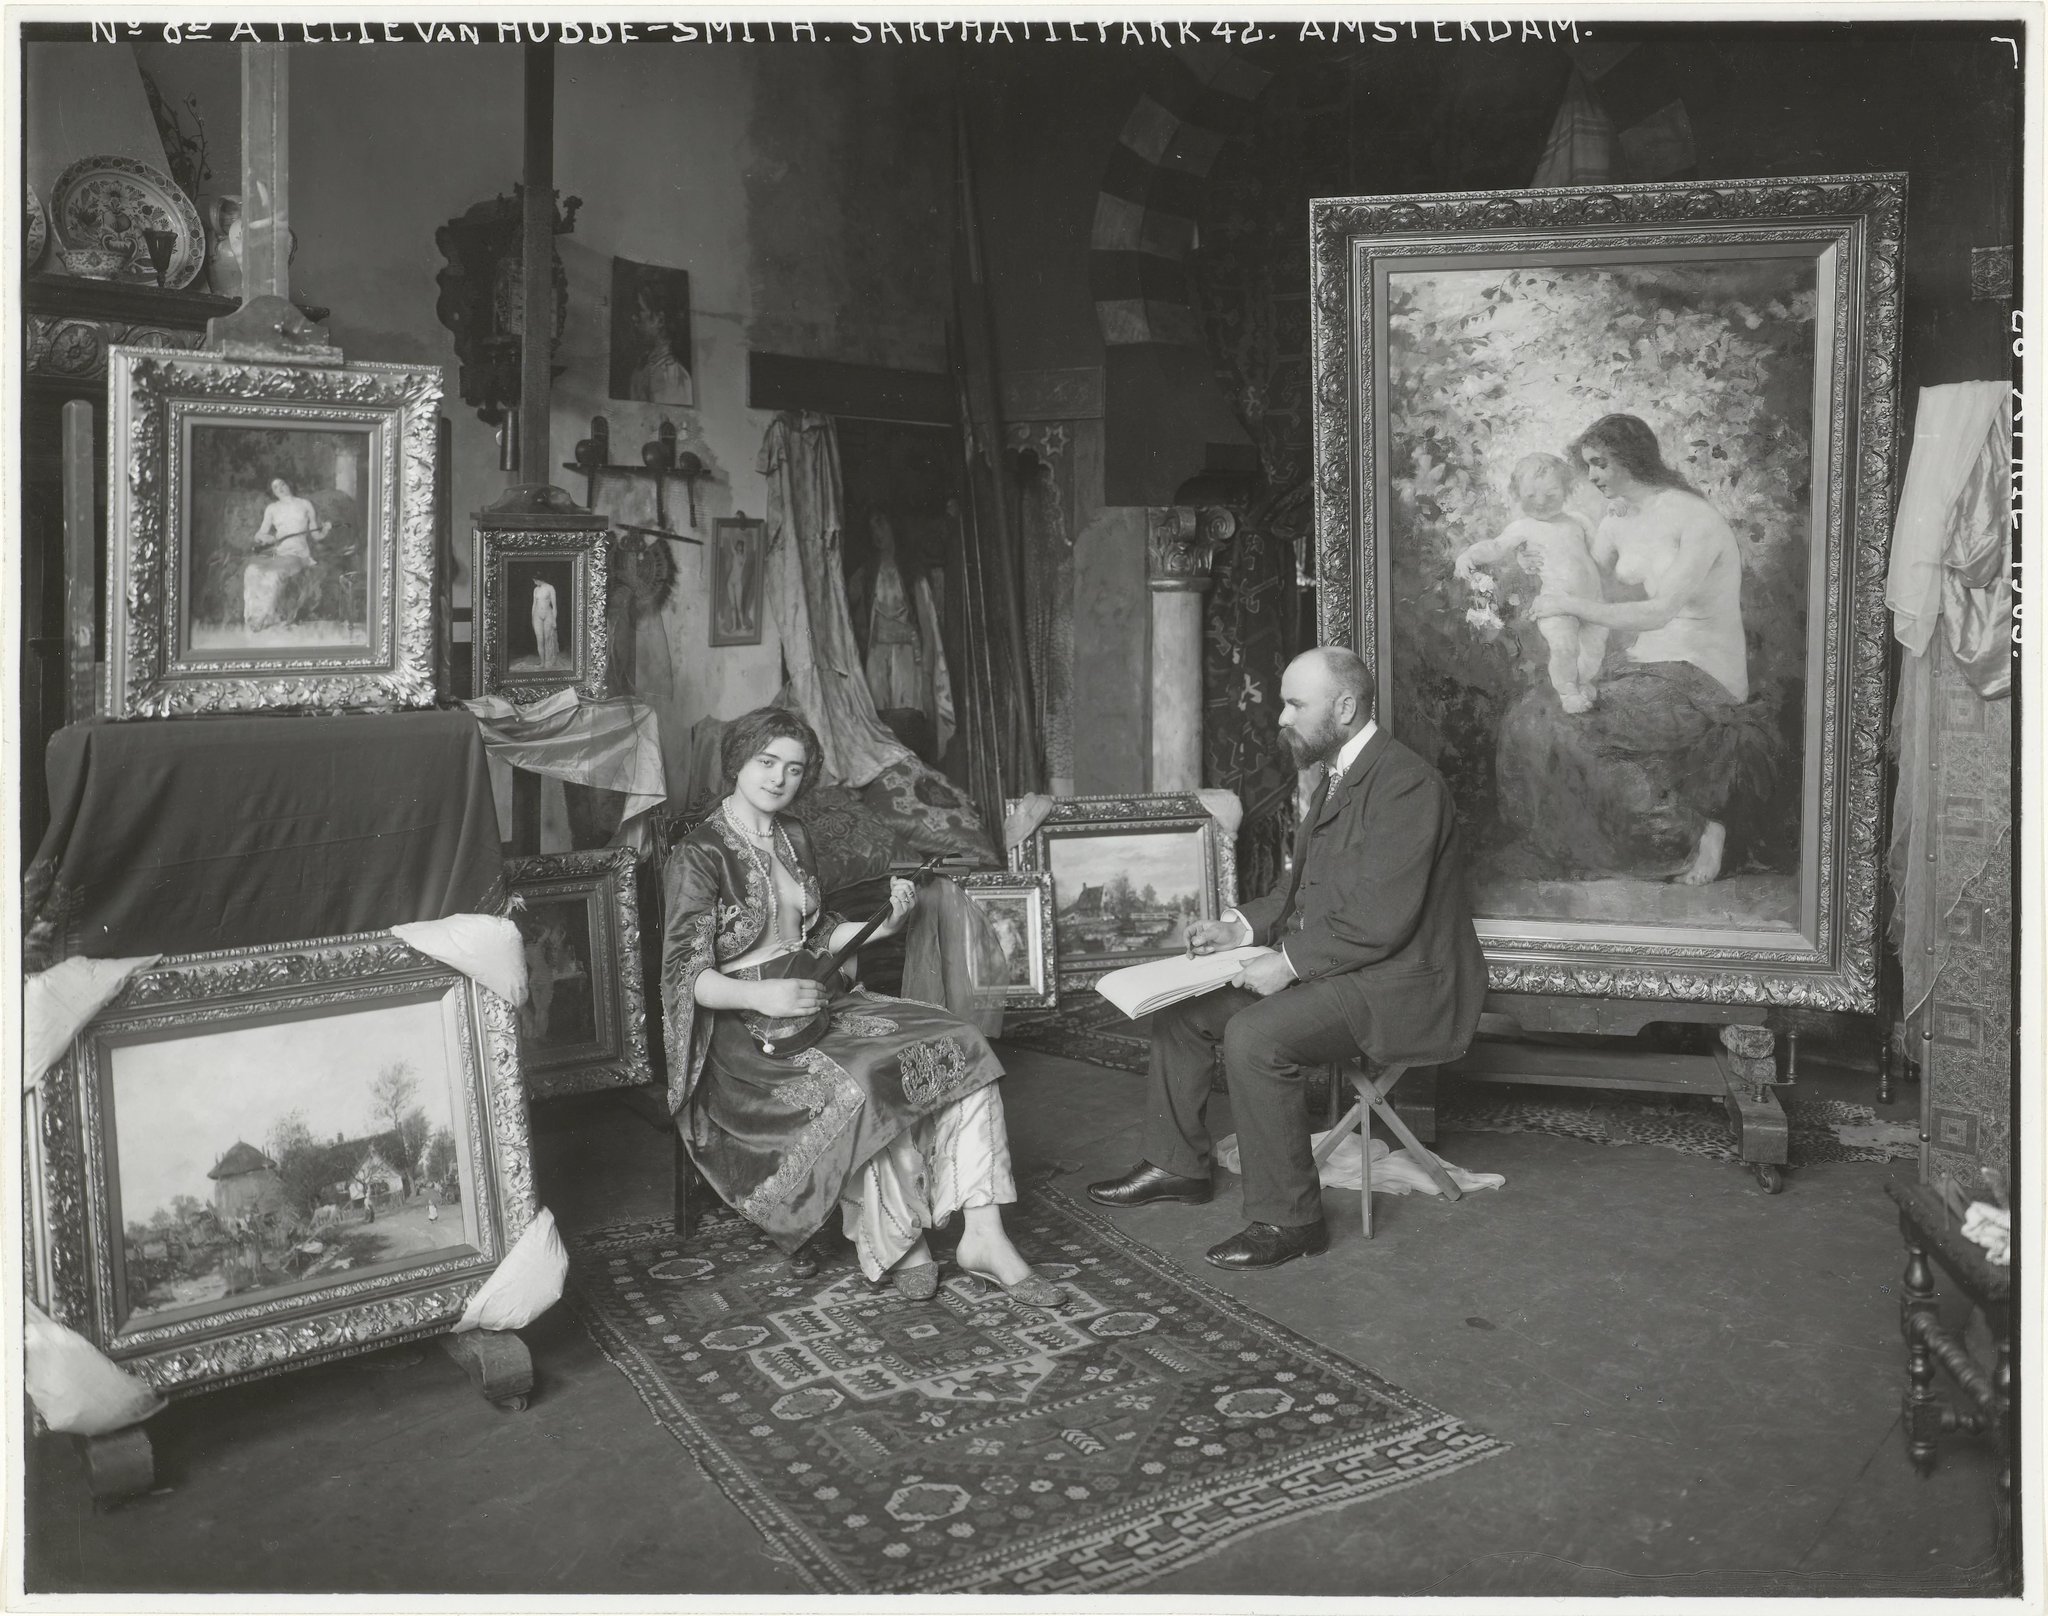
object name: later print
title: Schilder Hobbe Smith met een model in zijn atelier aan het Sarphatipark 42, Amsterdam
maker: sigmund löw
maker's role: publisher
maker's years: 1845-1920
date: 1903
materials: paper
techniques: gelatin silver print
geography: amsterdam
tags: hobbe smith, the painter and his muse, painter at work, in his studio, amsterdam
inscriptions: inscription: ‘No 8B ATELIE VAN HOBBE-SMITH. SARPHATIPARK 42. 42 AMSTERDAM./ 28 APRIL 1903.’